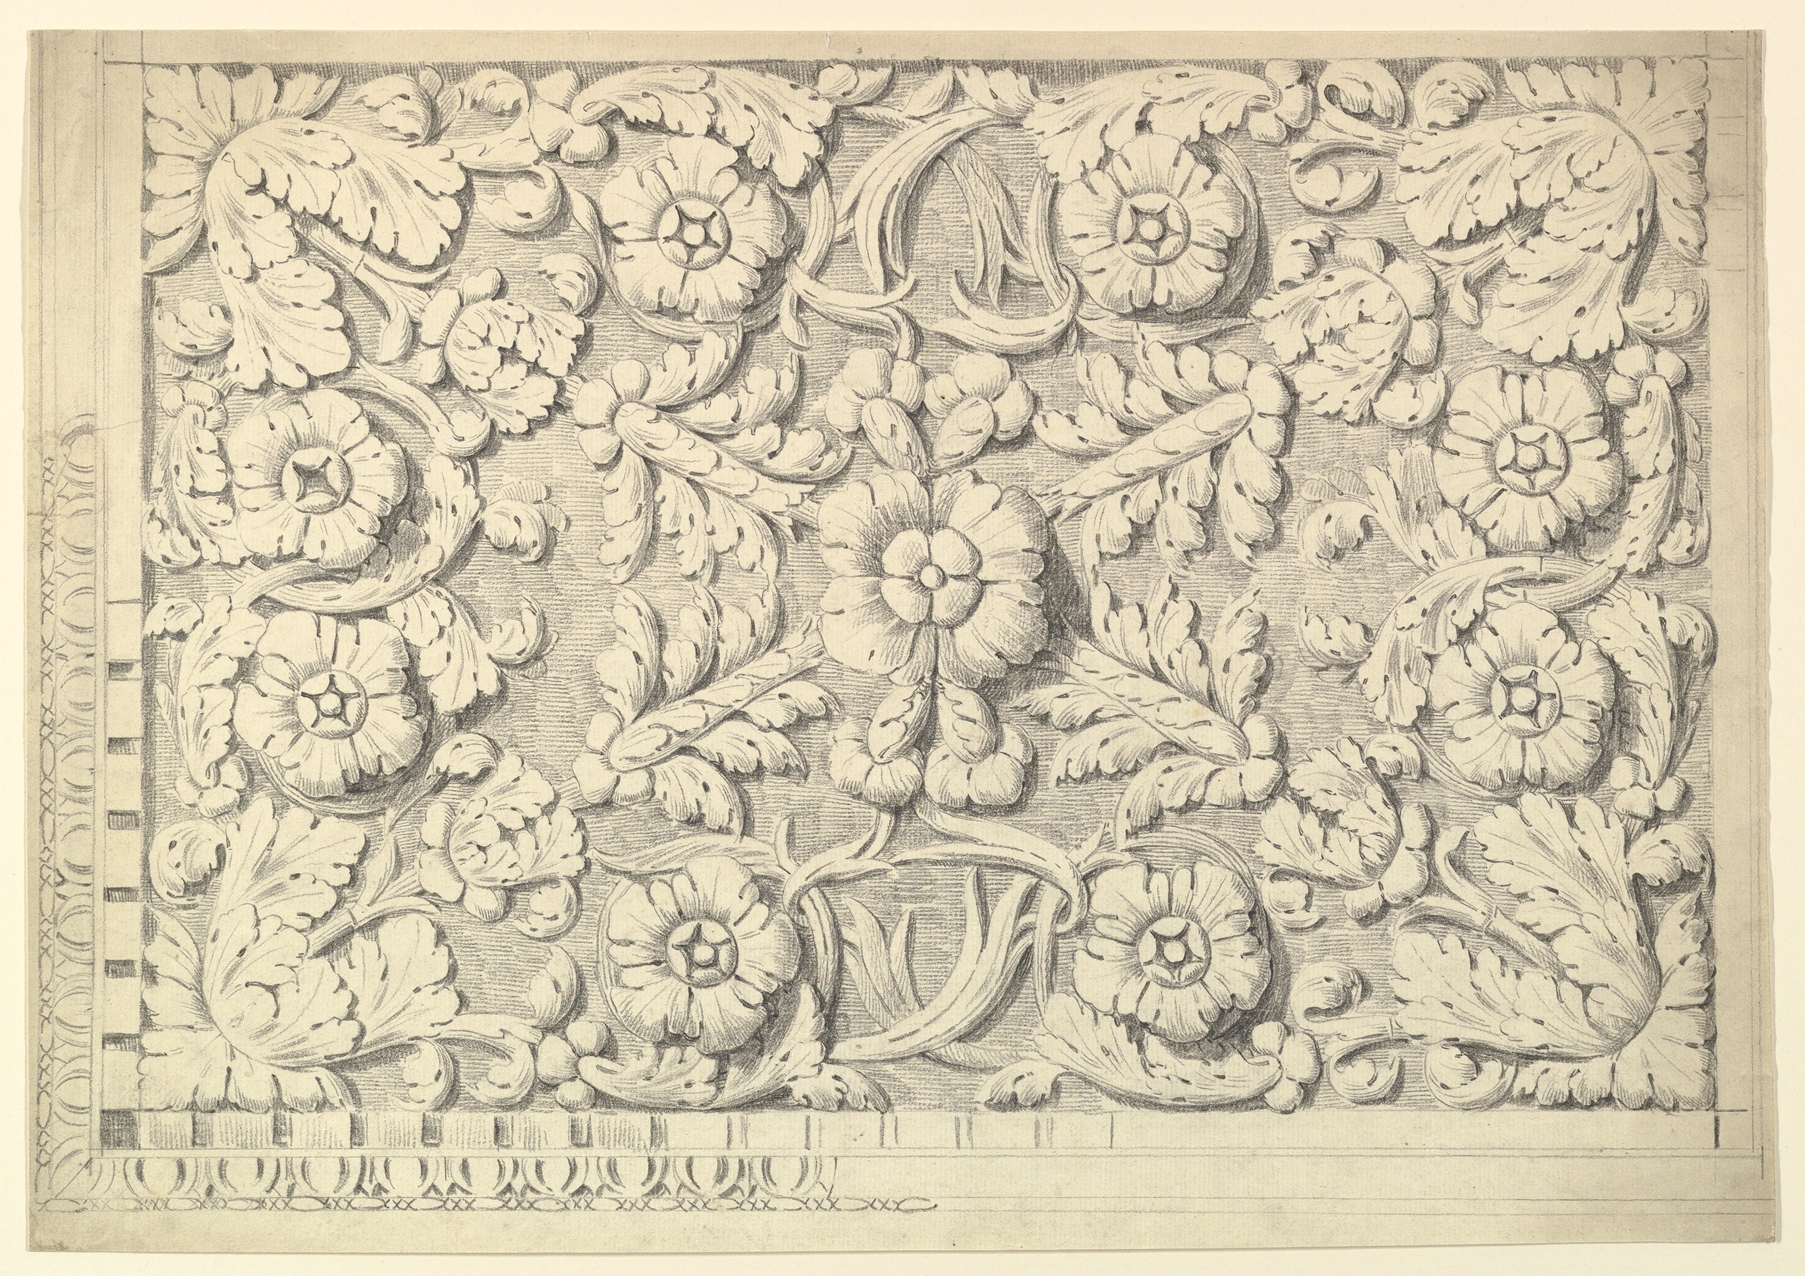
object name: drawing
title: Plaque with Ornamentation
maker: thomas hardwick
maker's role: artist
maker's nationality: british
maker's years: 1752-1829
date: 1776-1779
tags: flowers,leaves